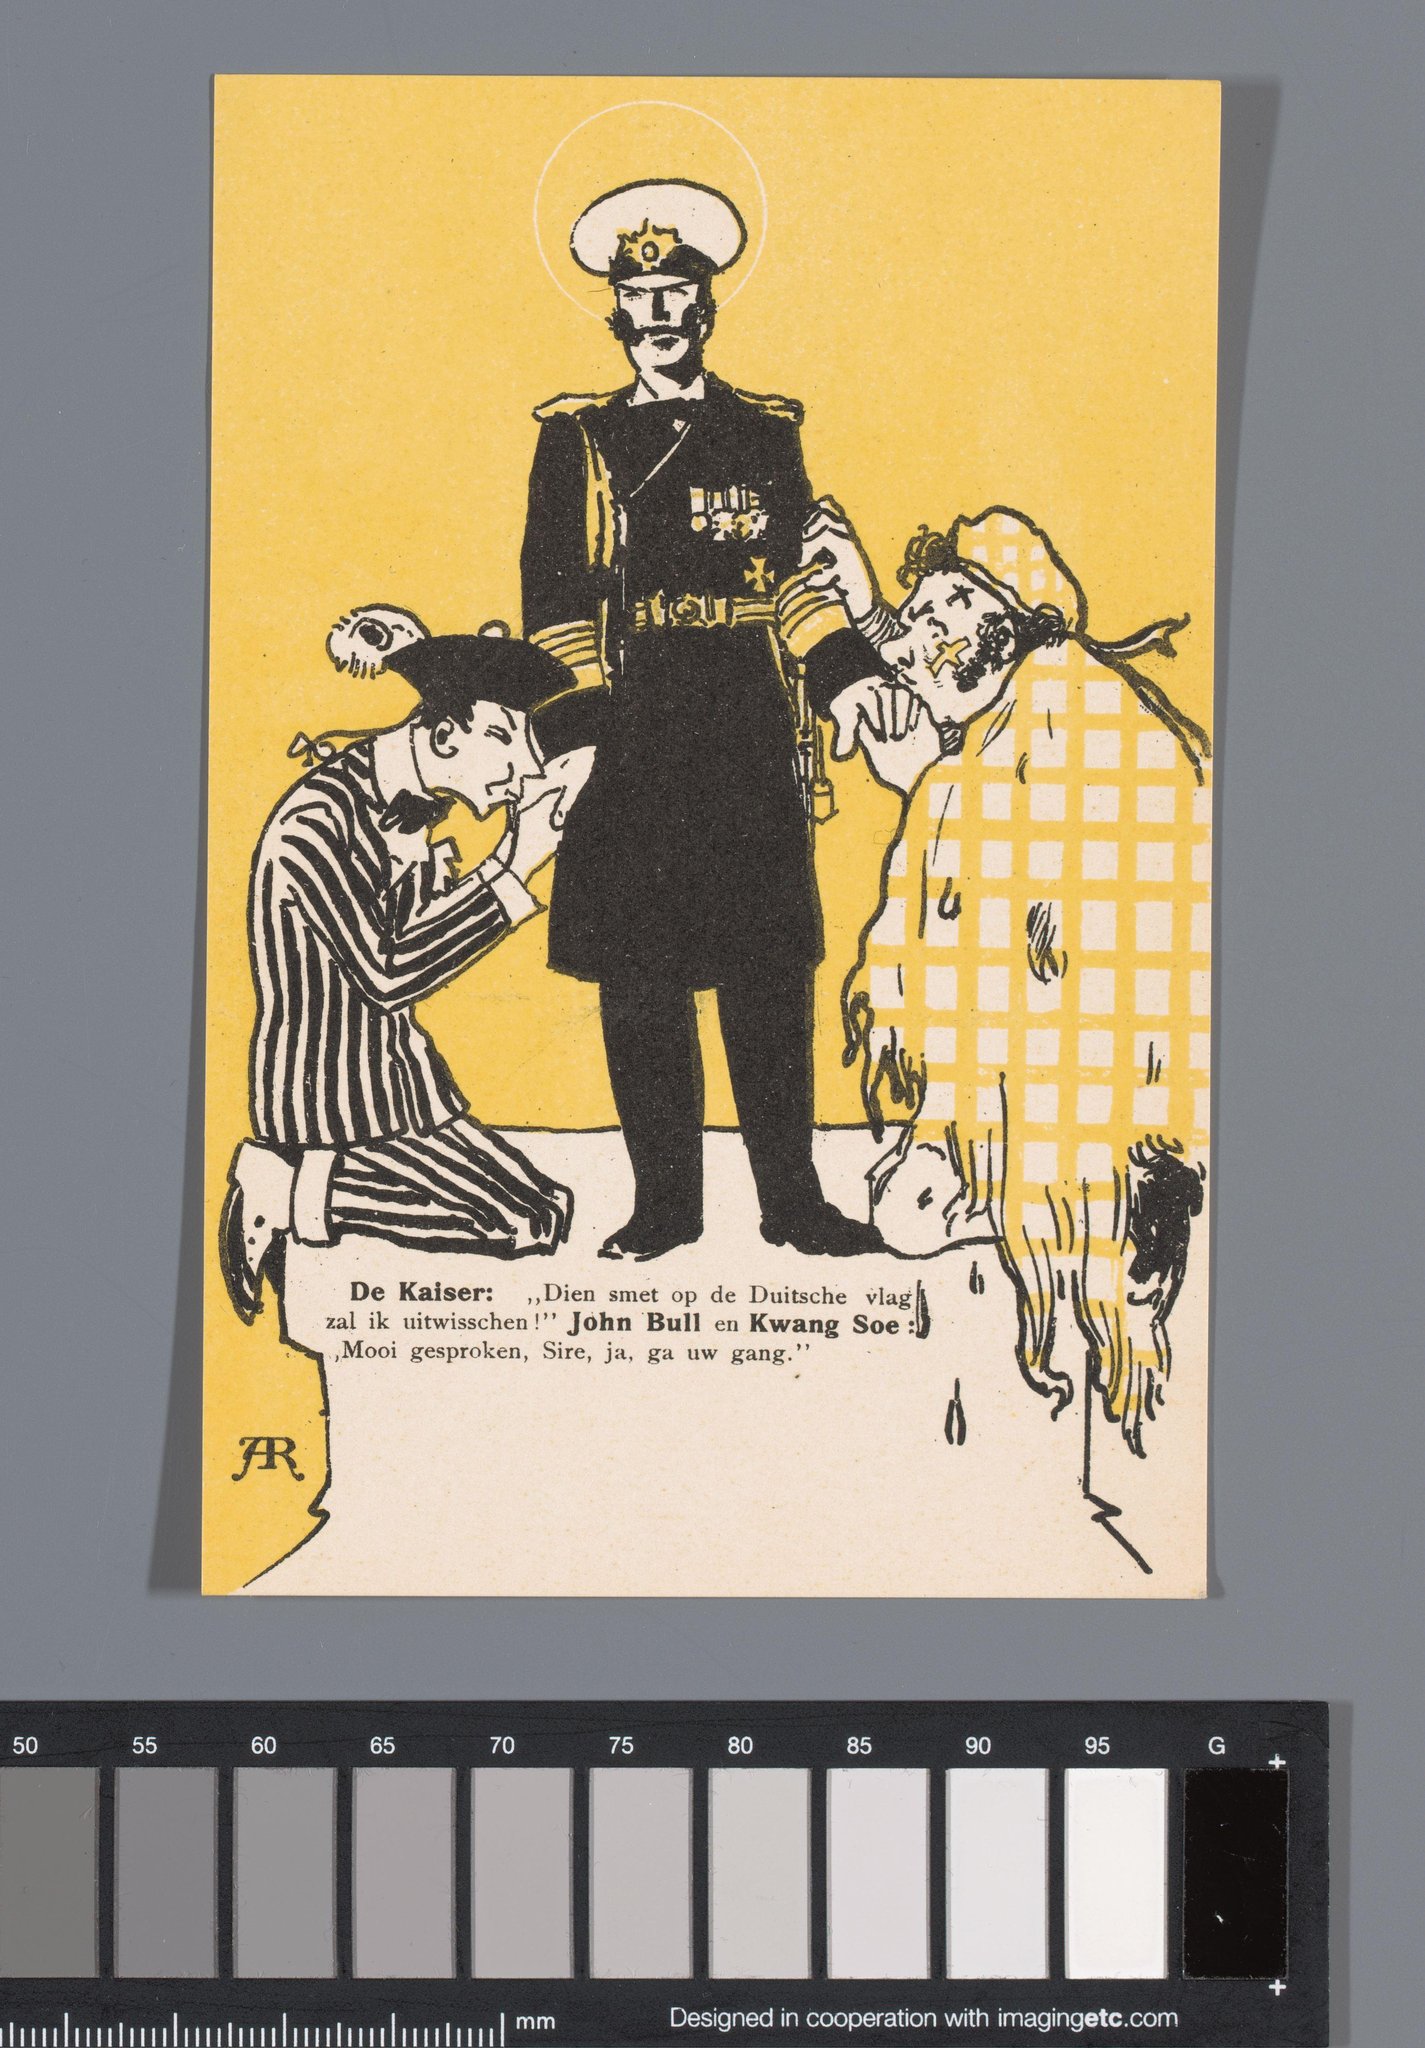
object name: ansichtkaart, prentbriefkaart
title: China prentbriefkaart 'De Kaiser'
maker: alfaro reijding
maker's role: draughtsman, engineer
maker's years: 1863-1930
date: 1900-1918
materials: paper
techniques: printing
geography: netherlands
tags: wilhelm ii (keizer van duitsland), personifications of countries, nations, states, districts, etc., political caricatures and satires, germany, china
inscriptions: : ‘De Kaiser: 'Dien smet op de Duitsche vlag / zal ik uitwisschen!" John Bull en Kwang Soe: / "Mooi gesproken, Sire, ja, ga uw gang."’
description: Prentbriefkaart in zwart en geel met twee knielende mannen, John Bull en Guangxu (Kwang-siu) die elk een hand van de staande keizer Wilhelm II kussen.